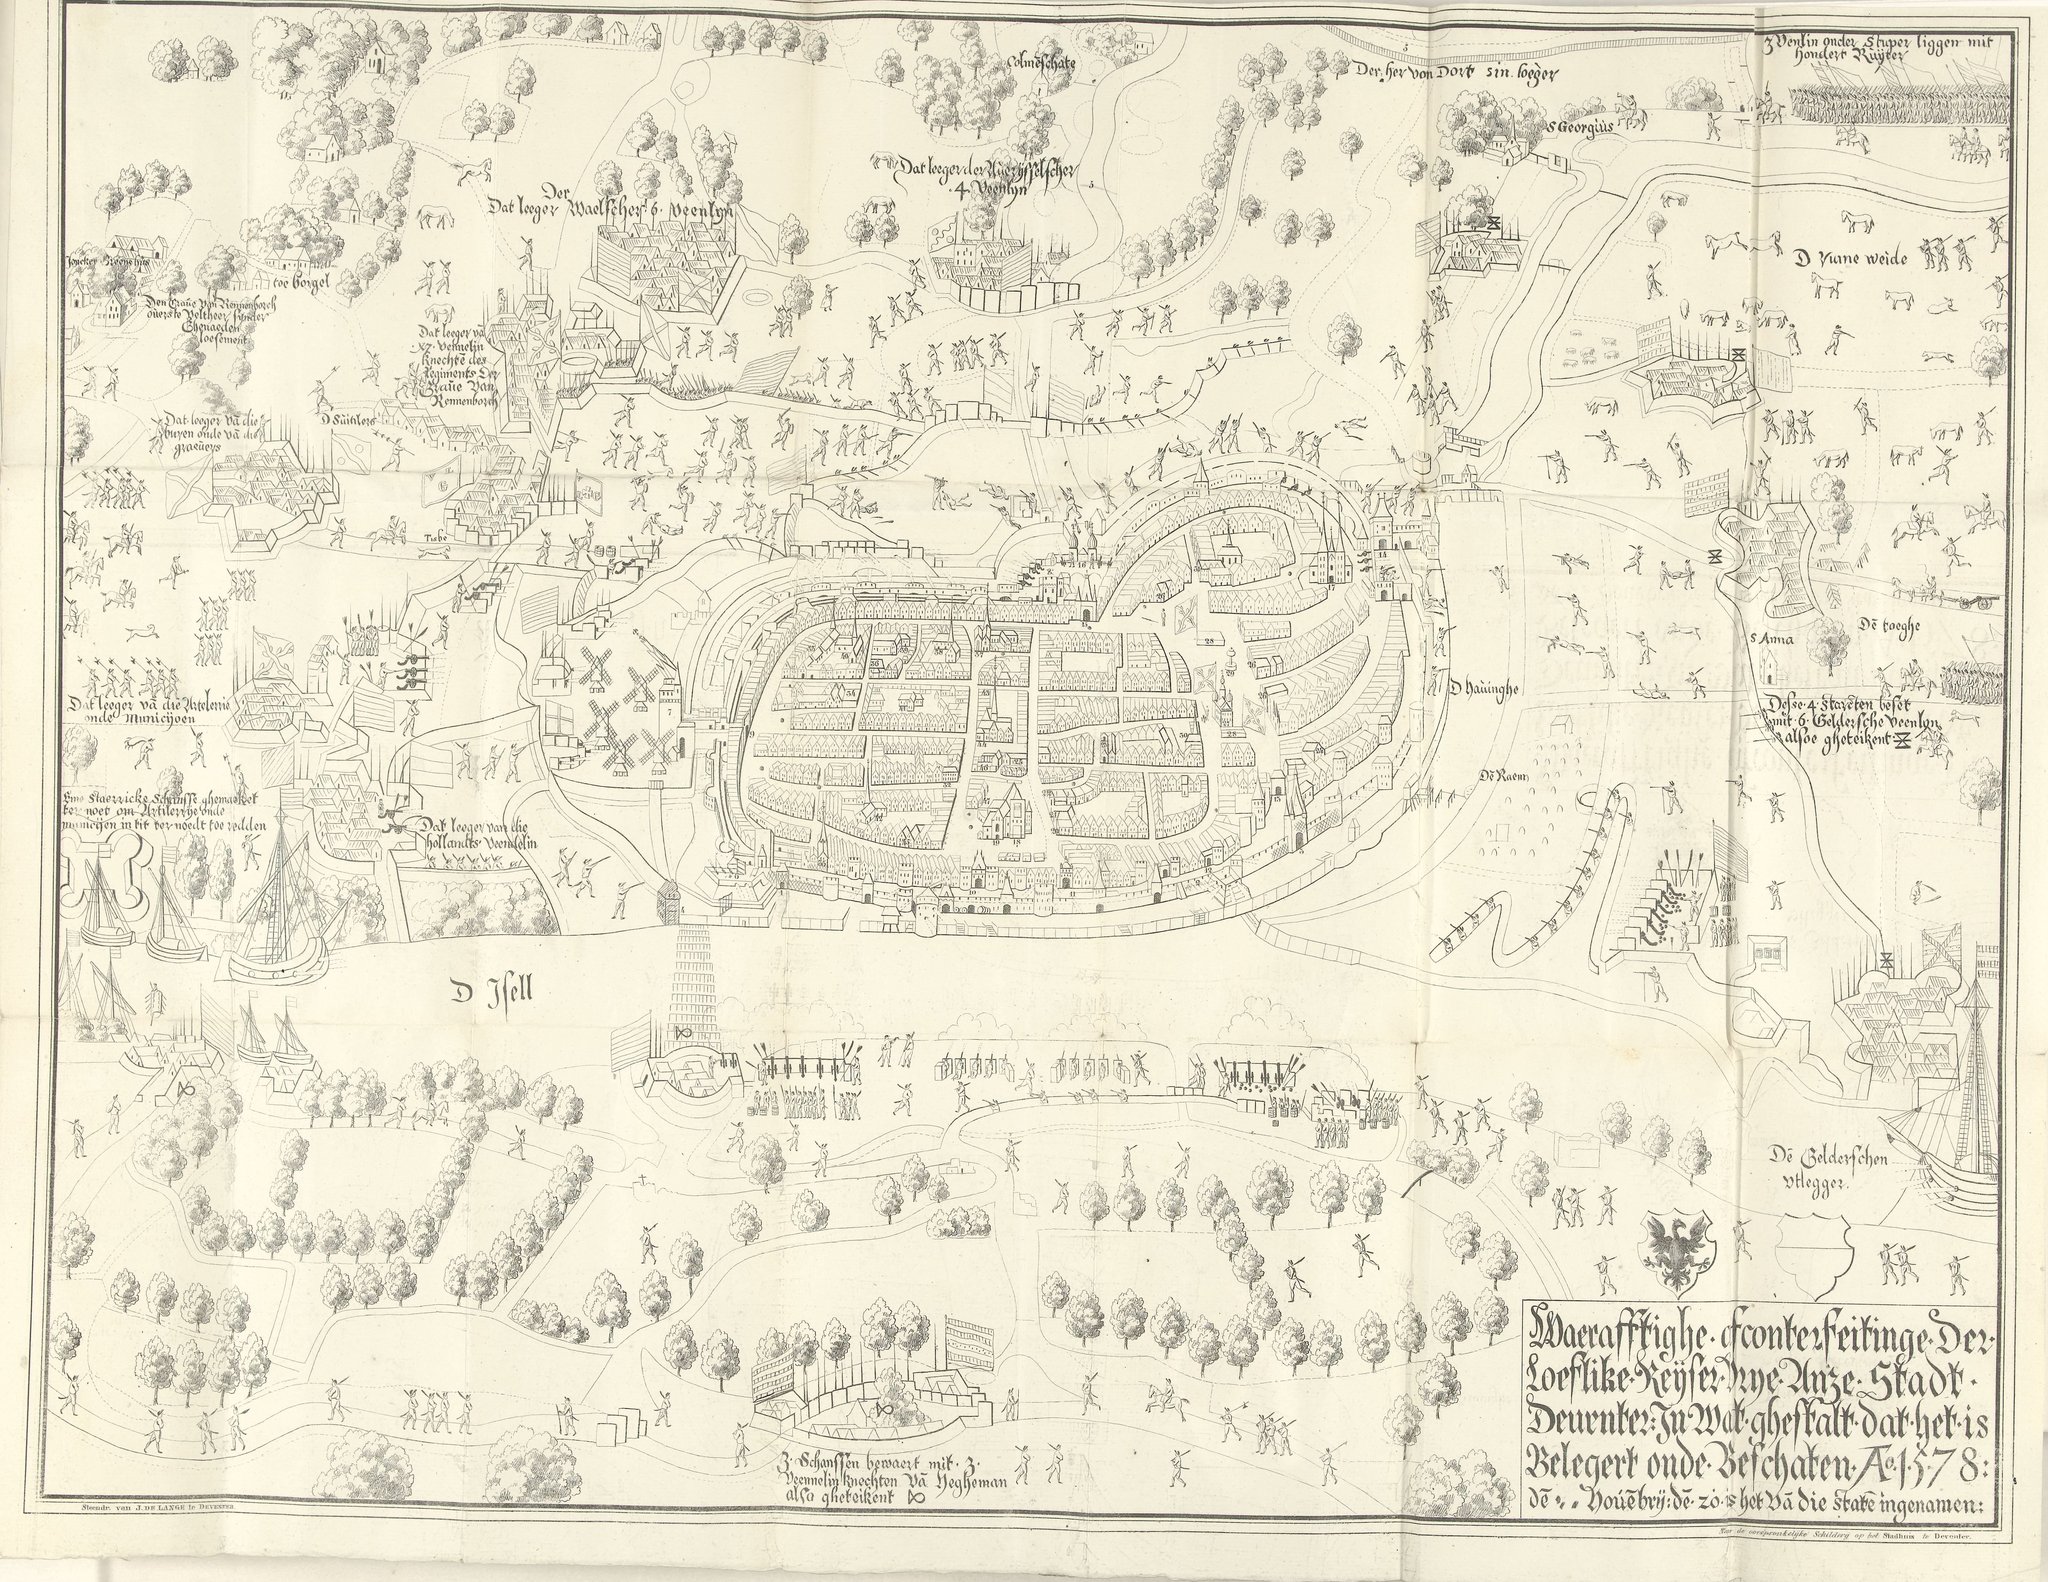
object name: history print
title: Waerafftighe afconterfeitinge der loeflike Keyser vrye Anze Stadt Deventer In wat ghestalt dat het is Belgert onde Beschaten Ao. 1578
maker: jan de lange (ii)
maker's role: printer, publisher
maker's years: 1799-1849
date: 1836-1838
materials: paper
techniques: lithograph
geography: deventer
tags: groningen (province), politician, capture of city (after the siege), deventer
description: Opgenomen als illustratie in: Overijsselsche almanak voor oudheid en letteren, jrg. 4 (1839), J. de Lange, Deventer 1838. Lithografie naar het oorspronkelijke schilderij op het stadhuis te Deventer.